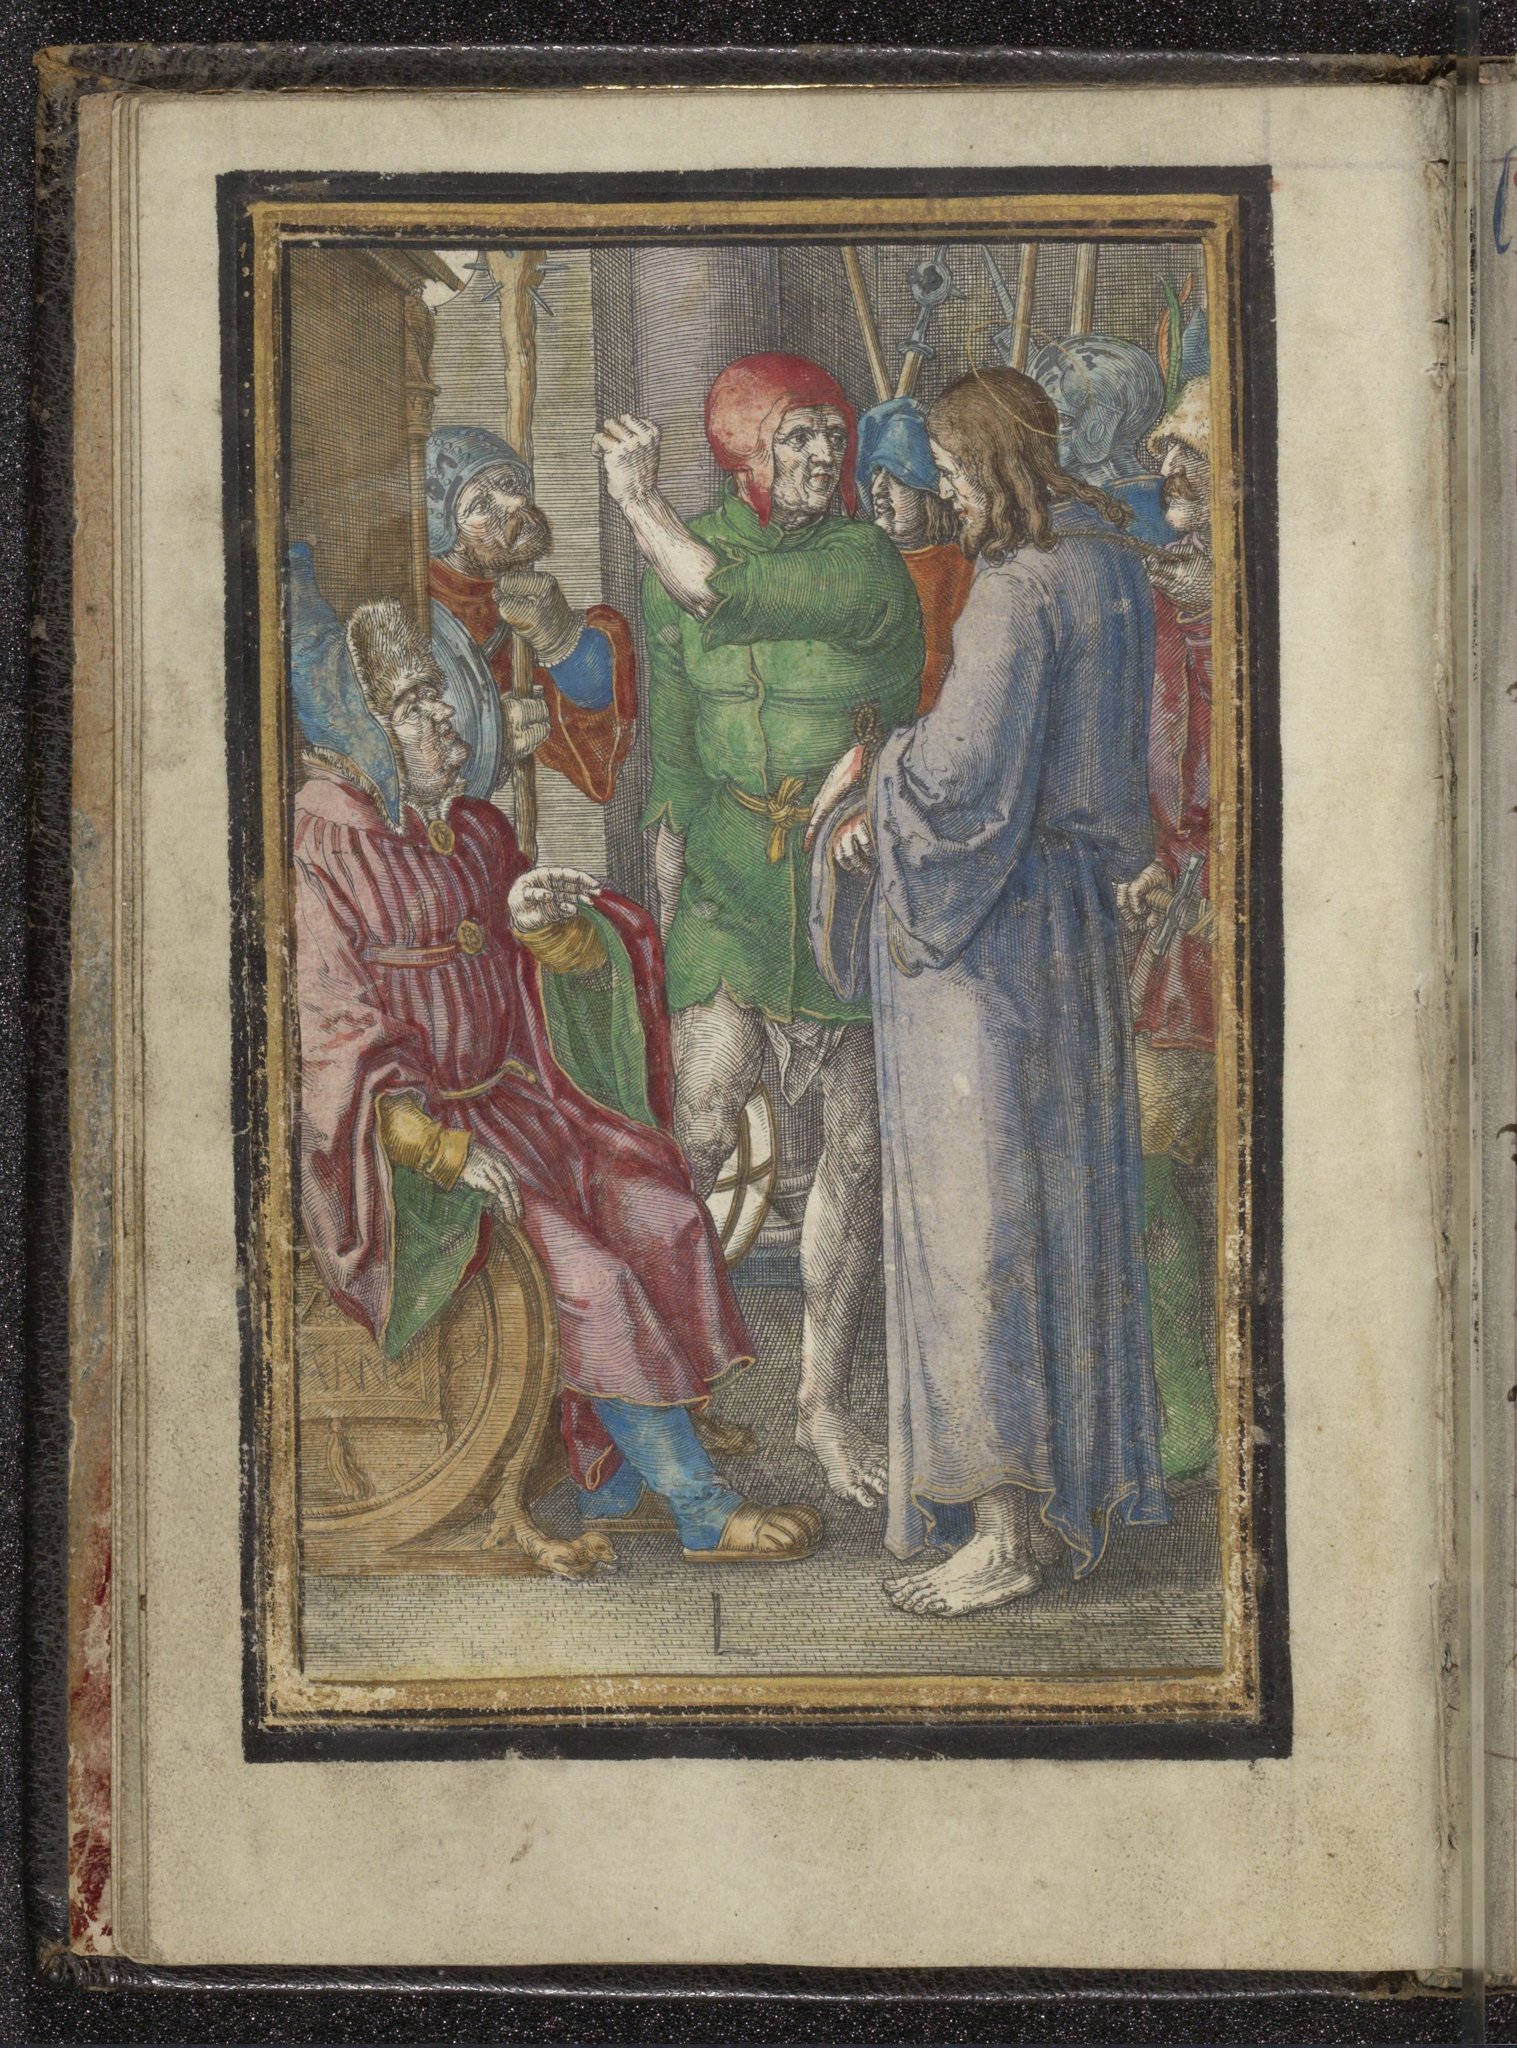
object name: print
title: Christus voor Annas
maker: lucas van leyden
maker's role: draughtsman, painter, print maker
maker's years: 1494-1533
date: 1521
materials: paper, parchment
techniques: engraving, hand coloring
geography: leiden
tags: christ before annas (hanna); maybe a soldier about to strike christ (john 18:13, 18:19-24)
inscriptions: date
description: Christus wordt, met gebonden handen, voor Annas gebracht. Annas zit op een troon en kijkt op. Op de achtergrond soldaten. Deze prent maakt deel uit van een handgeschreven gebedenboek.